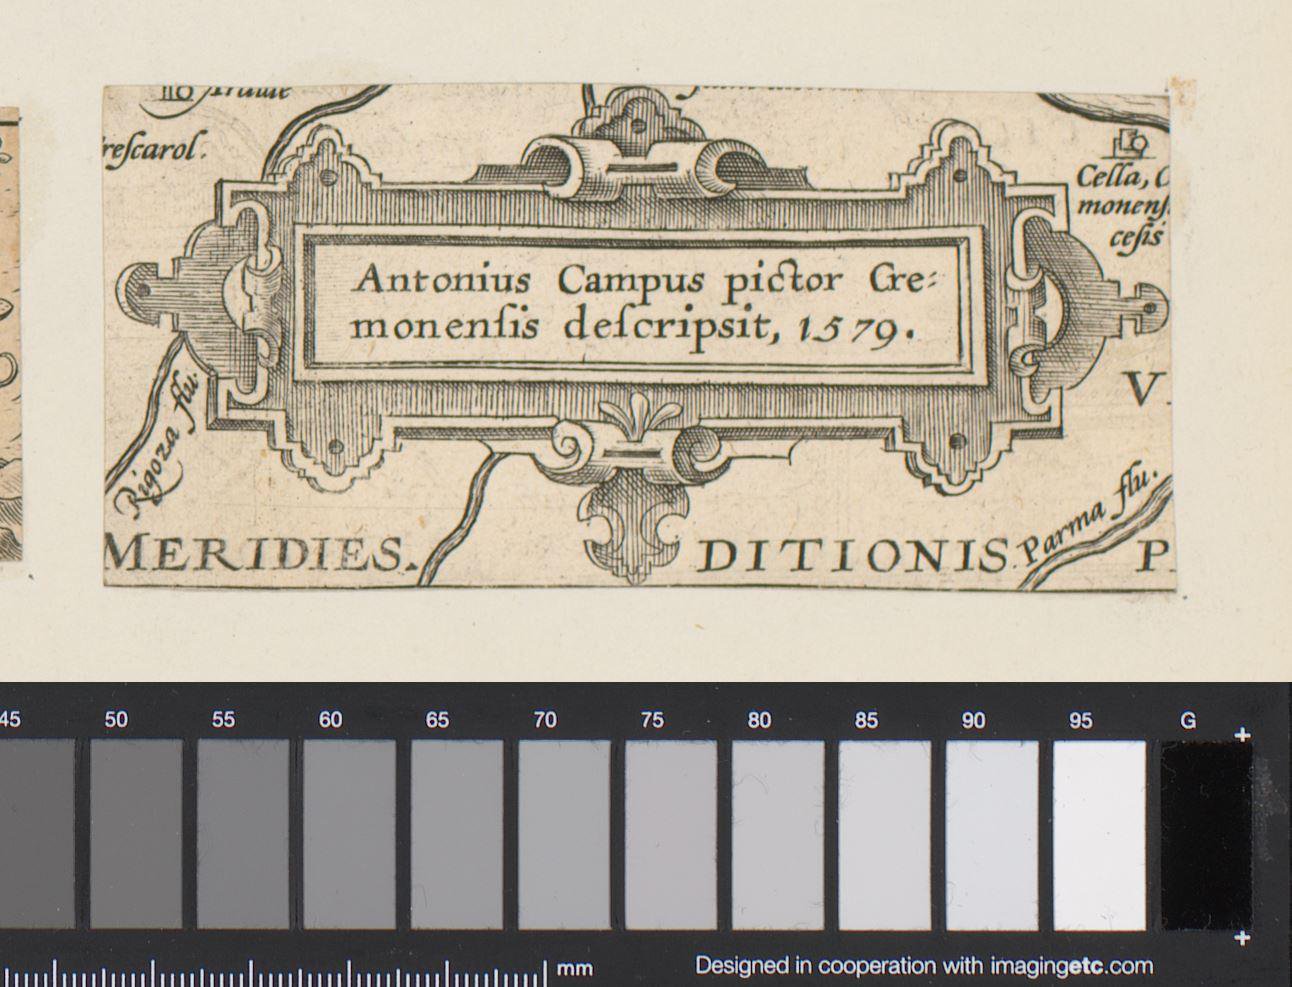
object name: print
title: Cartouche van een kaart van Cremona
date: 1579-1580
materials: paper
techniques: engraving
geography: antwerp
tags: scrollwork, strapwork ~ ornament, ornament ~ cartouche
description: Langwerpige cartouche met rolwerk. De cartouche is een fragment van een kaart van Cremona. De prent maakt deel uit van een album.